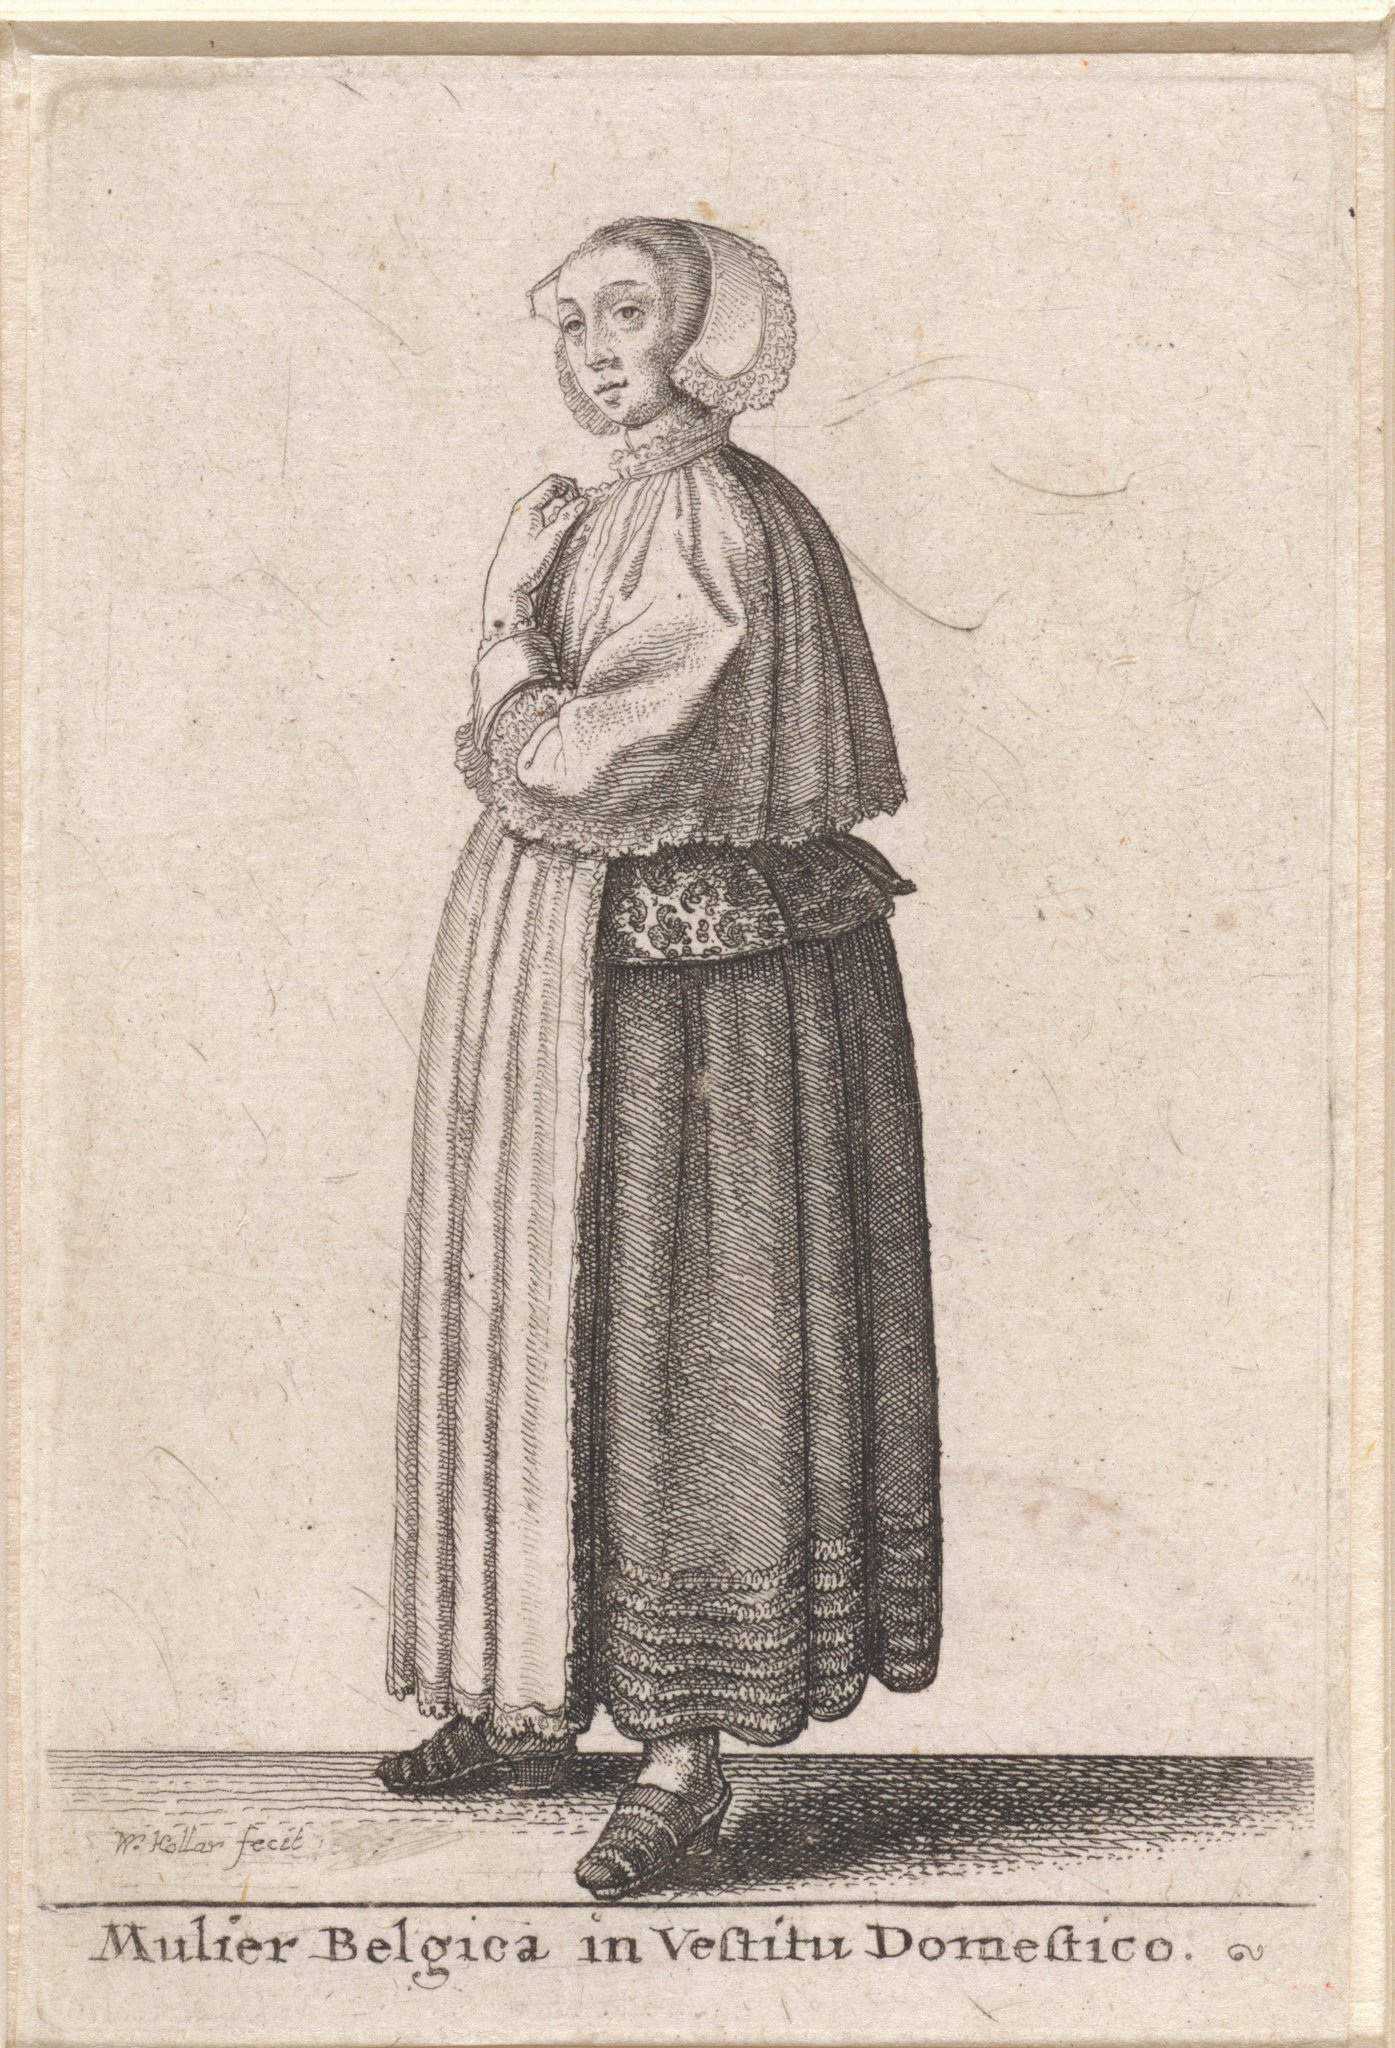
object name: costume print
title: Europese vrouwen in klederdracht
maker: wenceslaus hollar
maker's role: draughtsman, print maker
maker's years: 1607-1677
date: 1643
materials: paper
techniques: etching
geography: london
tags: europeans (dutch) (+ women), fibula, safety pin (+ women's clothes), head-gear: cap (+ women's clothes), shoes, sandals (+ women's clothes), skirt (+ women's clothes), apron (+ women's clothes), clothing for the upper part of the body (with name) (+ women's clothes), low countries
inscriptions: collector's mark: Lugt 240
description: Vrouw uit Vlaanderen naar links gekeerd, in huisdracht. Het haar is vanaf het gezicht strak naar achteren gekamd en grotendeels bedekt met een mutsje met een fijn geplooide teruggeslagen rand afgezet met kant. Het lijkt alsof rechts boven de slaap een voorhoofdsnaald met hanger naar voren steekt. Een geplooide kamdoek met smal opstaand boord en rondom afgezet met een geschulpte strook, bedekt het lijf of jak vrijwel geheel. Alleen de schoot, die uit verschillende panden bestaat is vanaf de taille tot de heup zichtbaar. Een ruime, enkellange rok is boven de zoom versierd met een aantal horizontale banden. Lang geplooid schort, rondom afgezet met een geschulpte strook. Versierde muilen met blokhak.